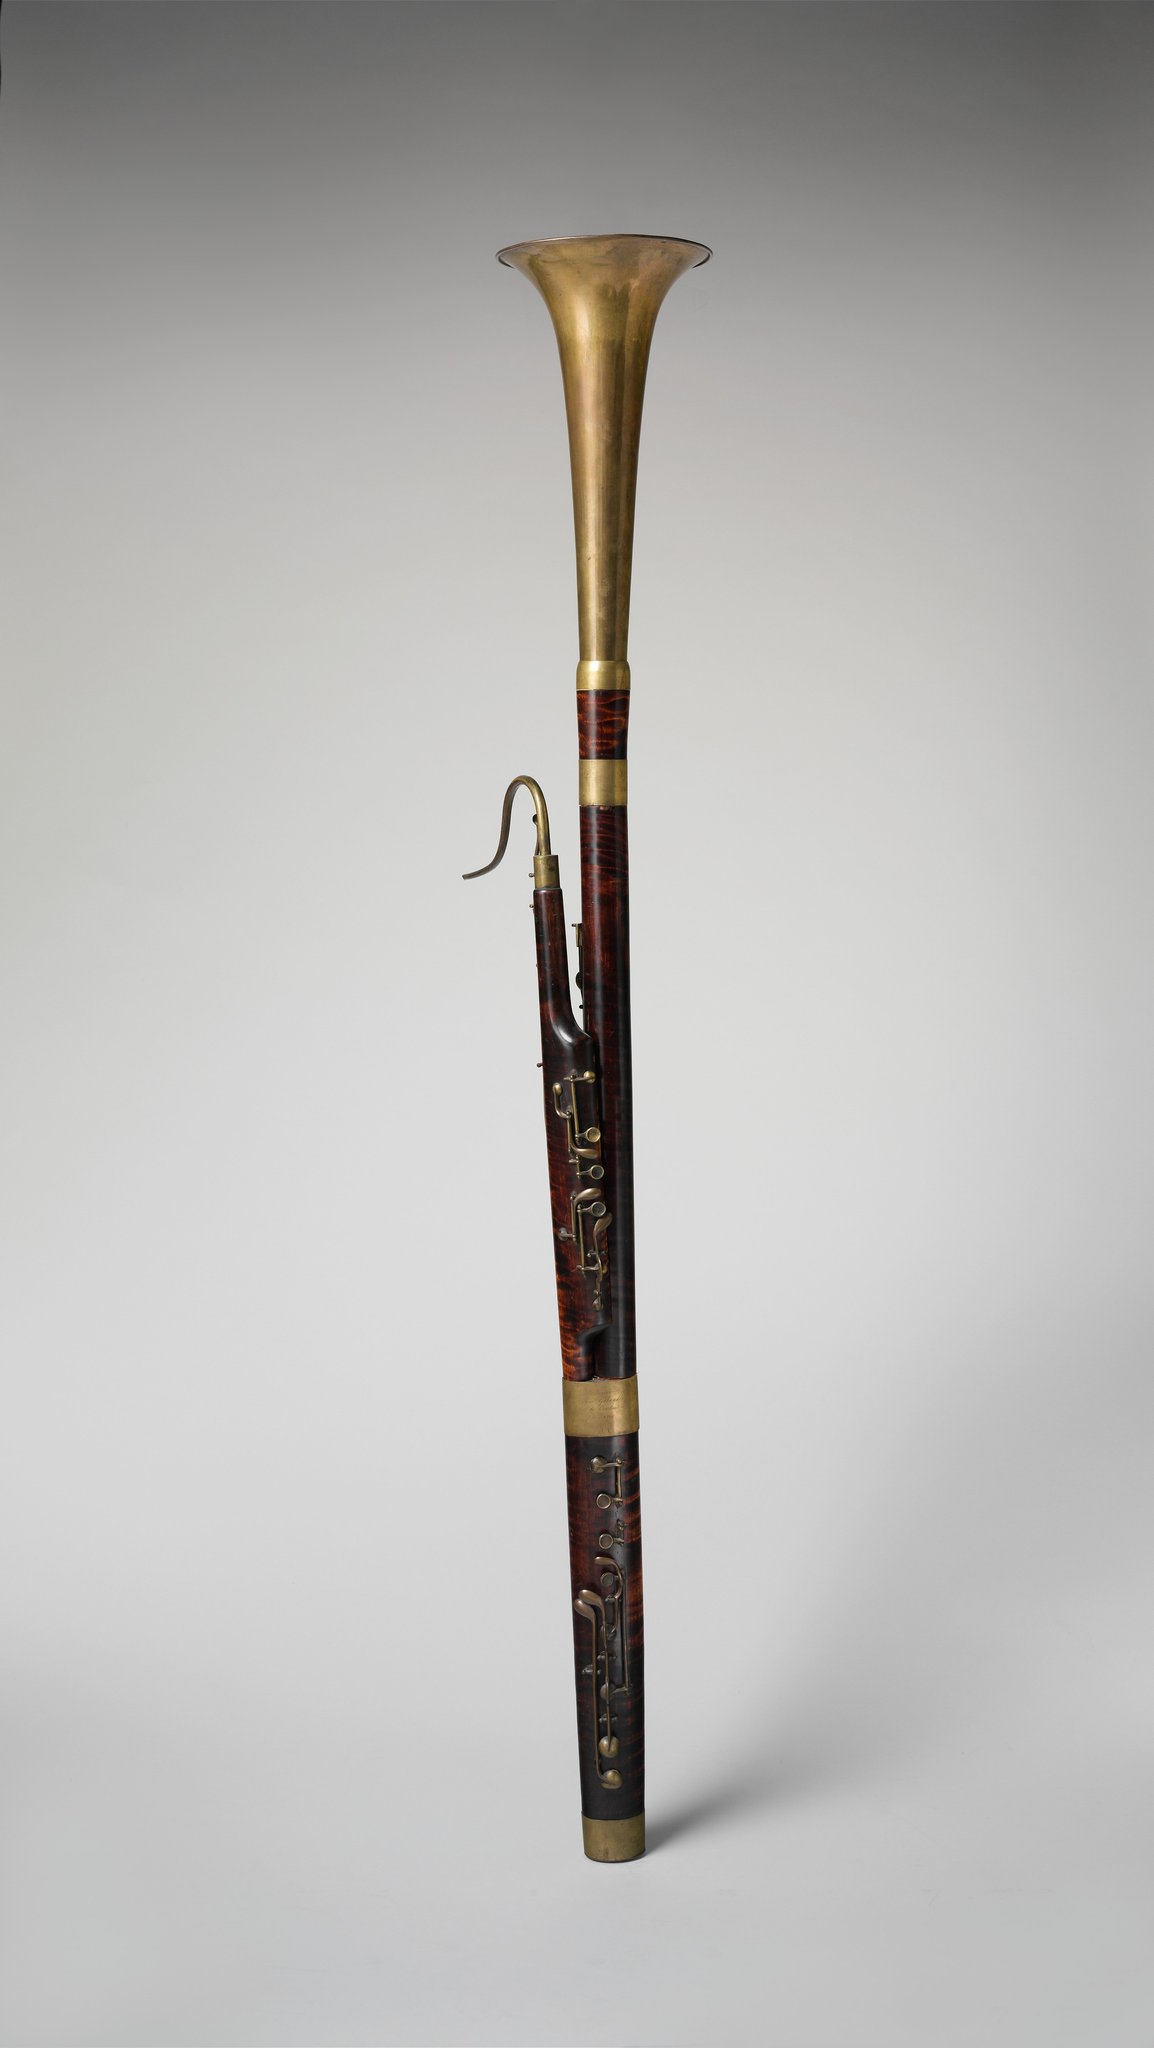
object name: half contra bassoon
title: Half-Contra Bassoon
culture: french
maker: galander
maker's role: maker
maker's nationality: french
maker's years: 1834-1855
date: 1853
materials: brass, wood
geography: france